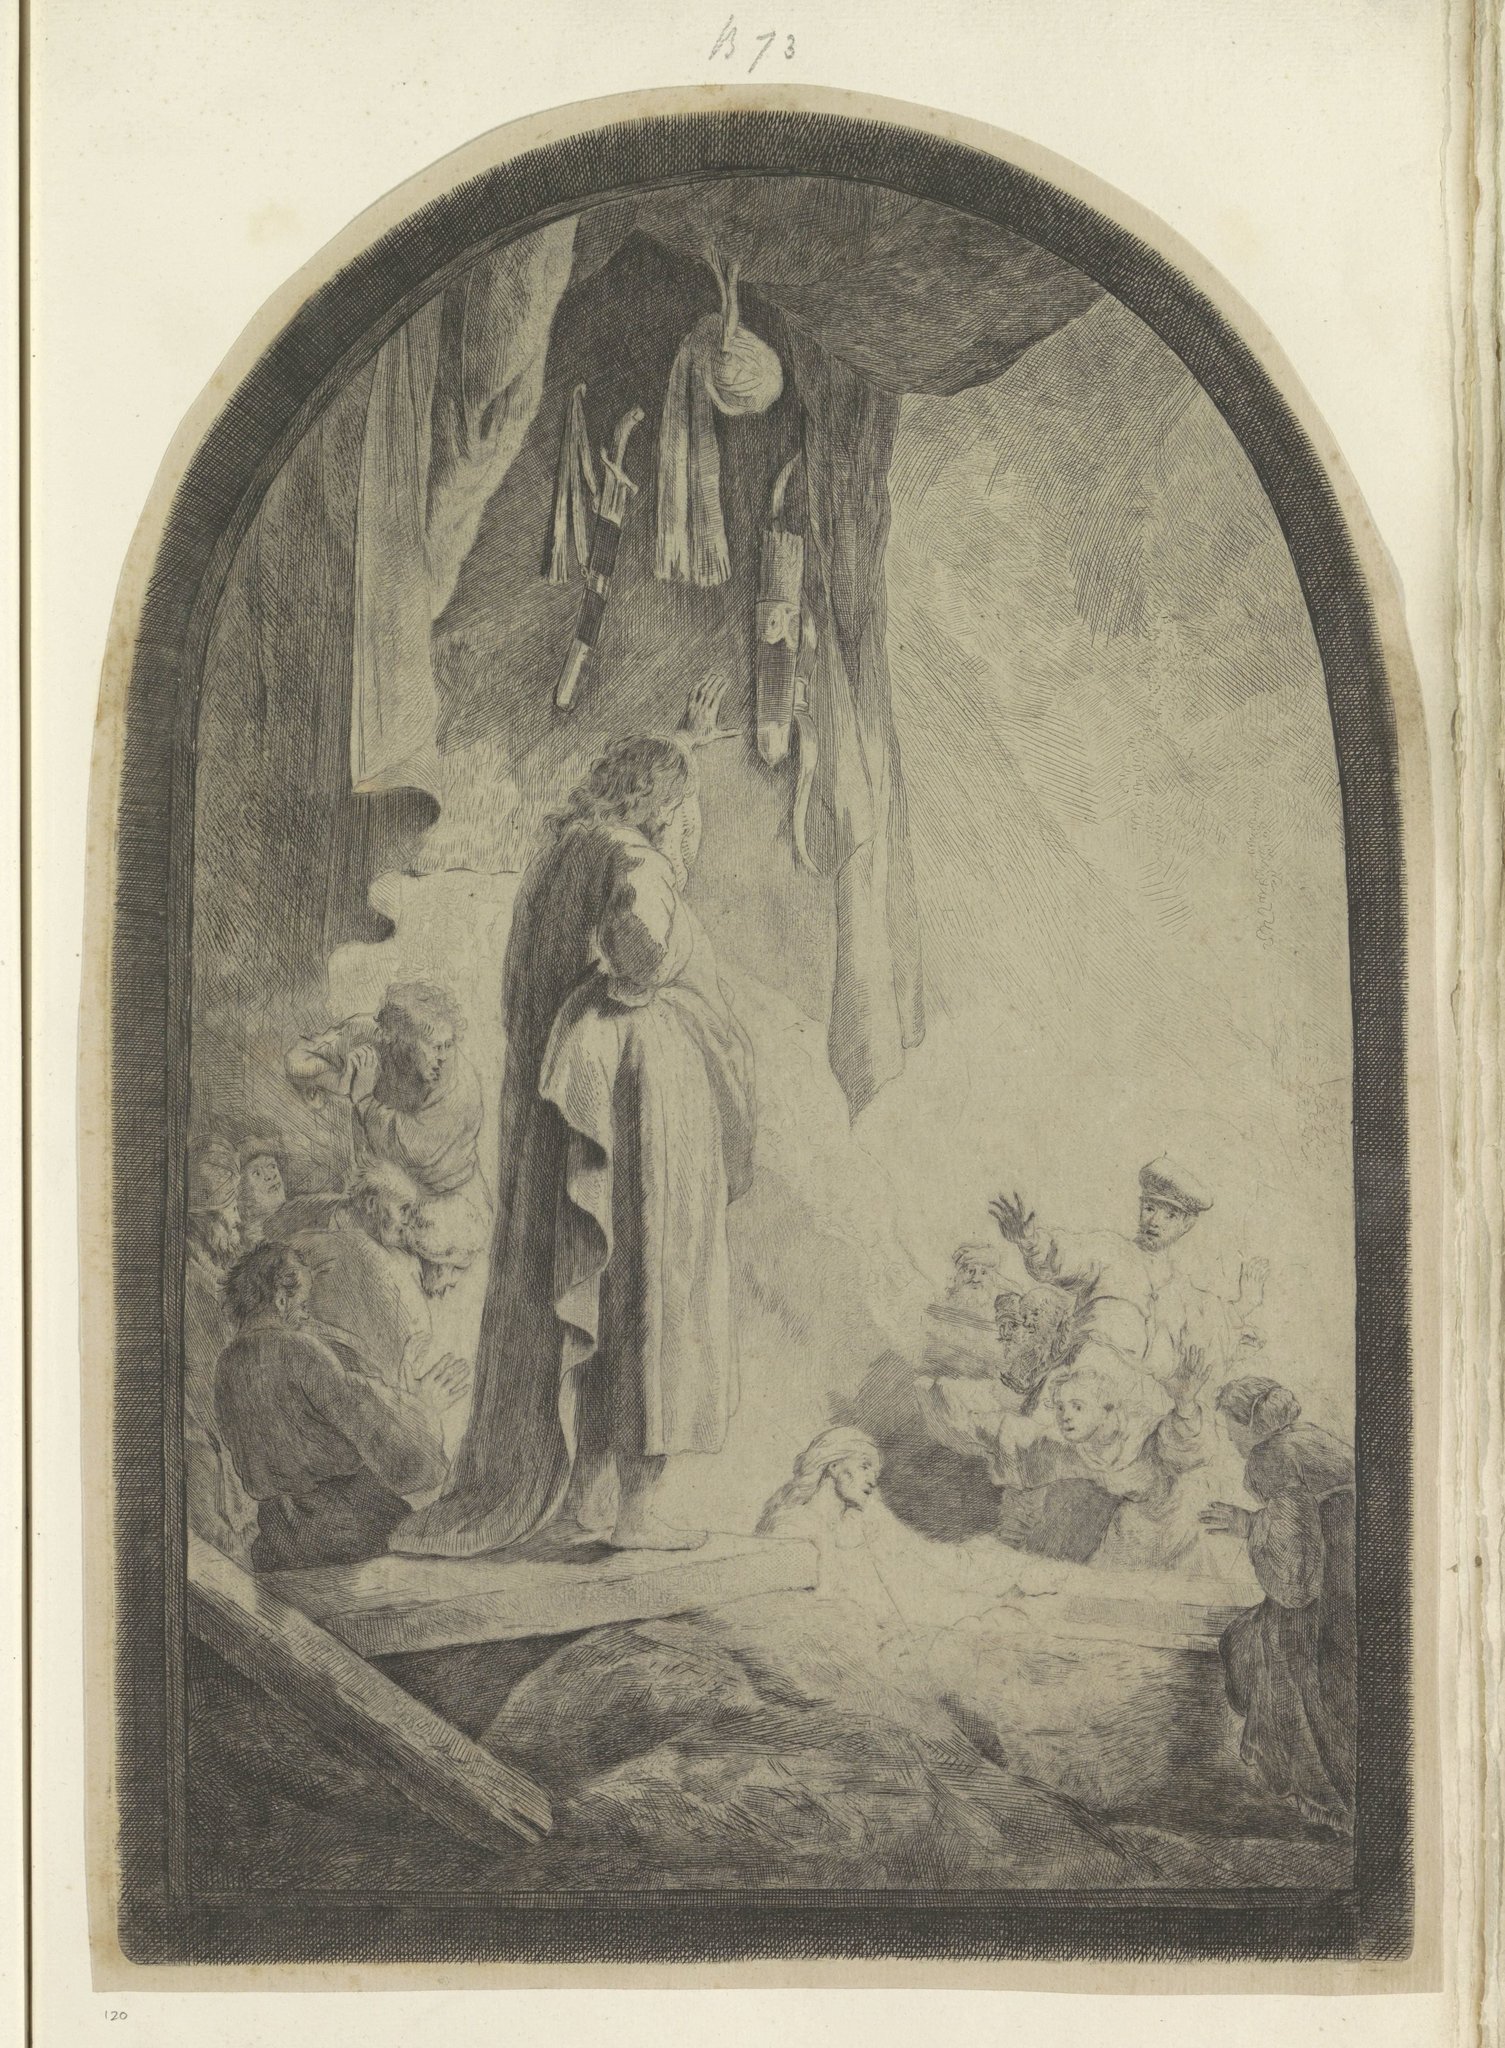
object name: print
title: Opwekking van Lazarus: grote plaat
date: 1630-1634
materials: paper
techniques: engraving, etching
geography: paris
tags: the raising of lazarus ('lazarus, come out')